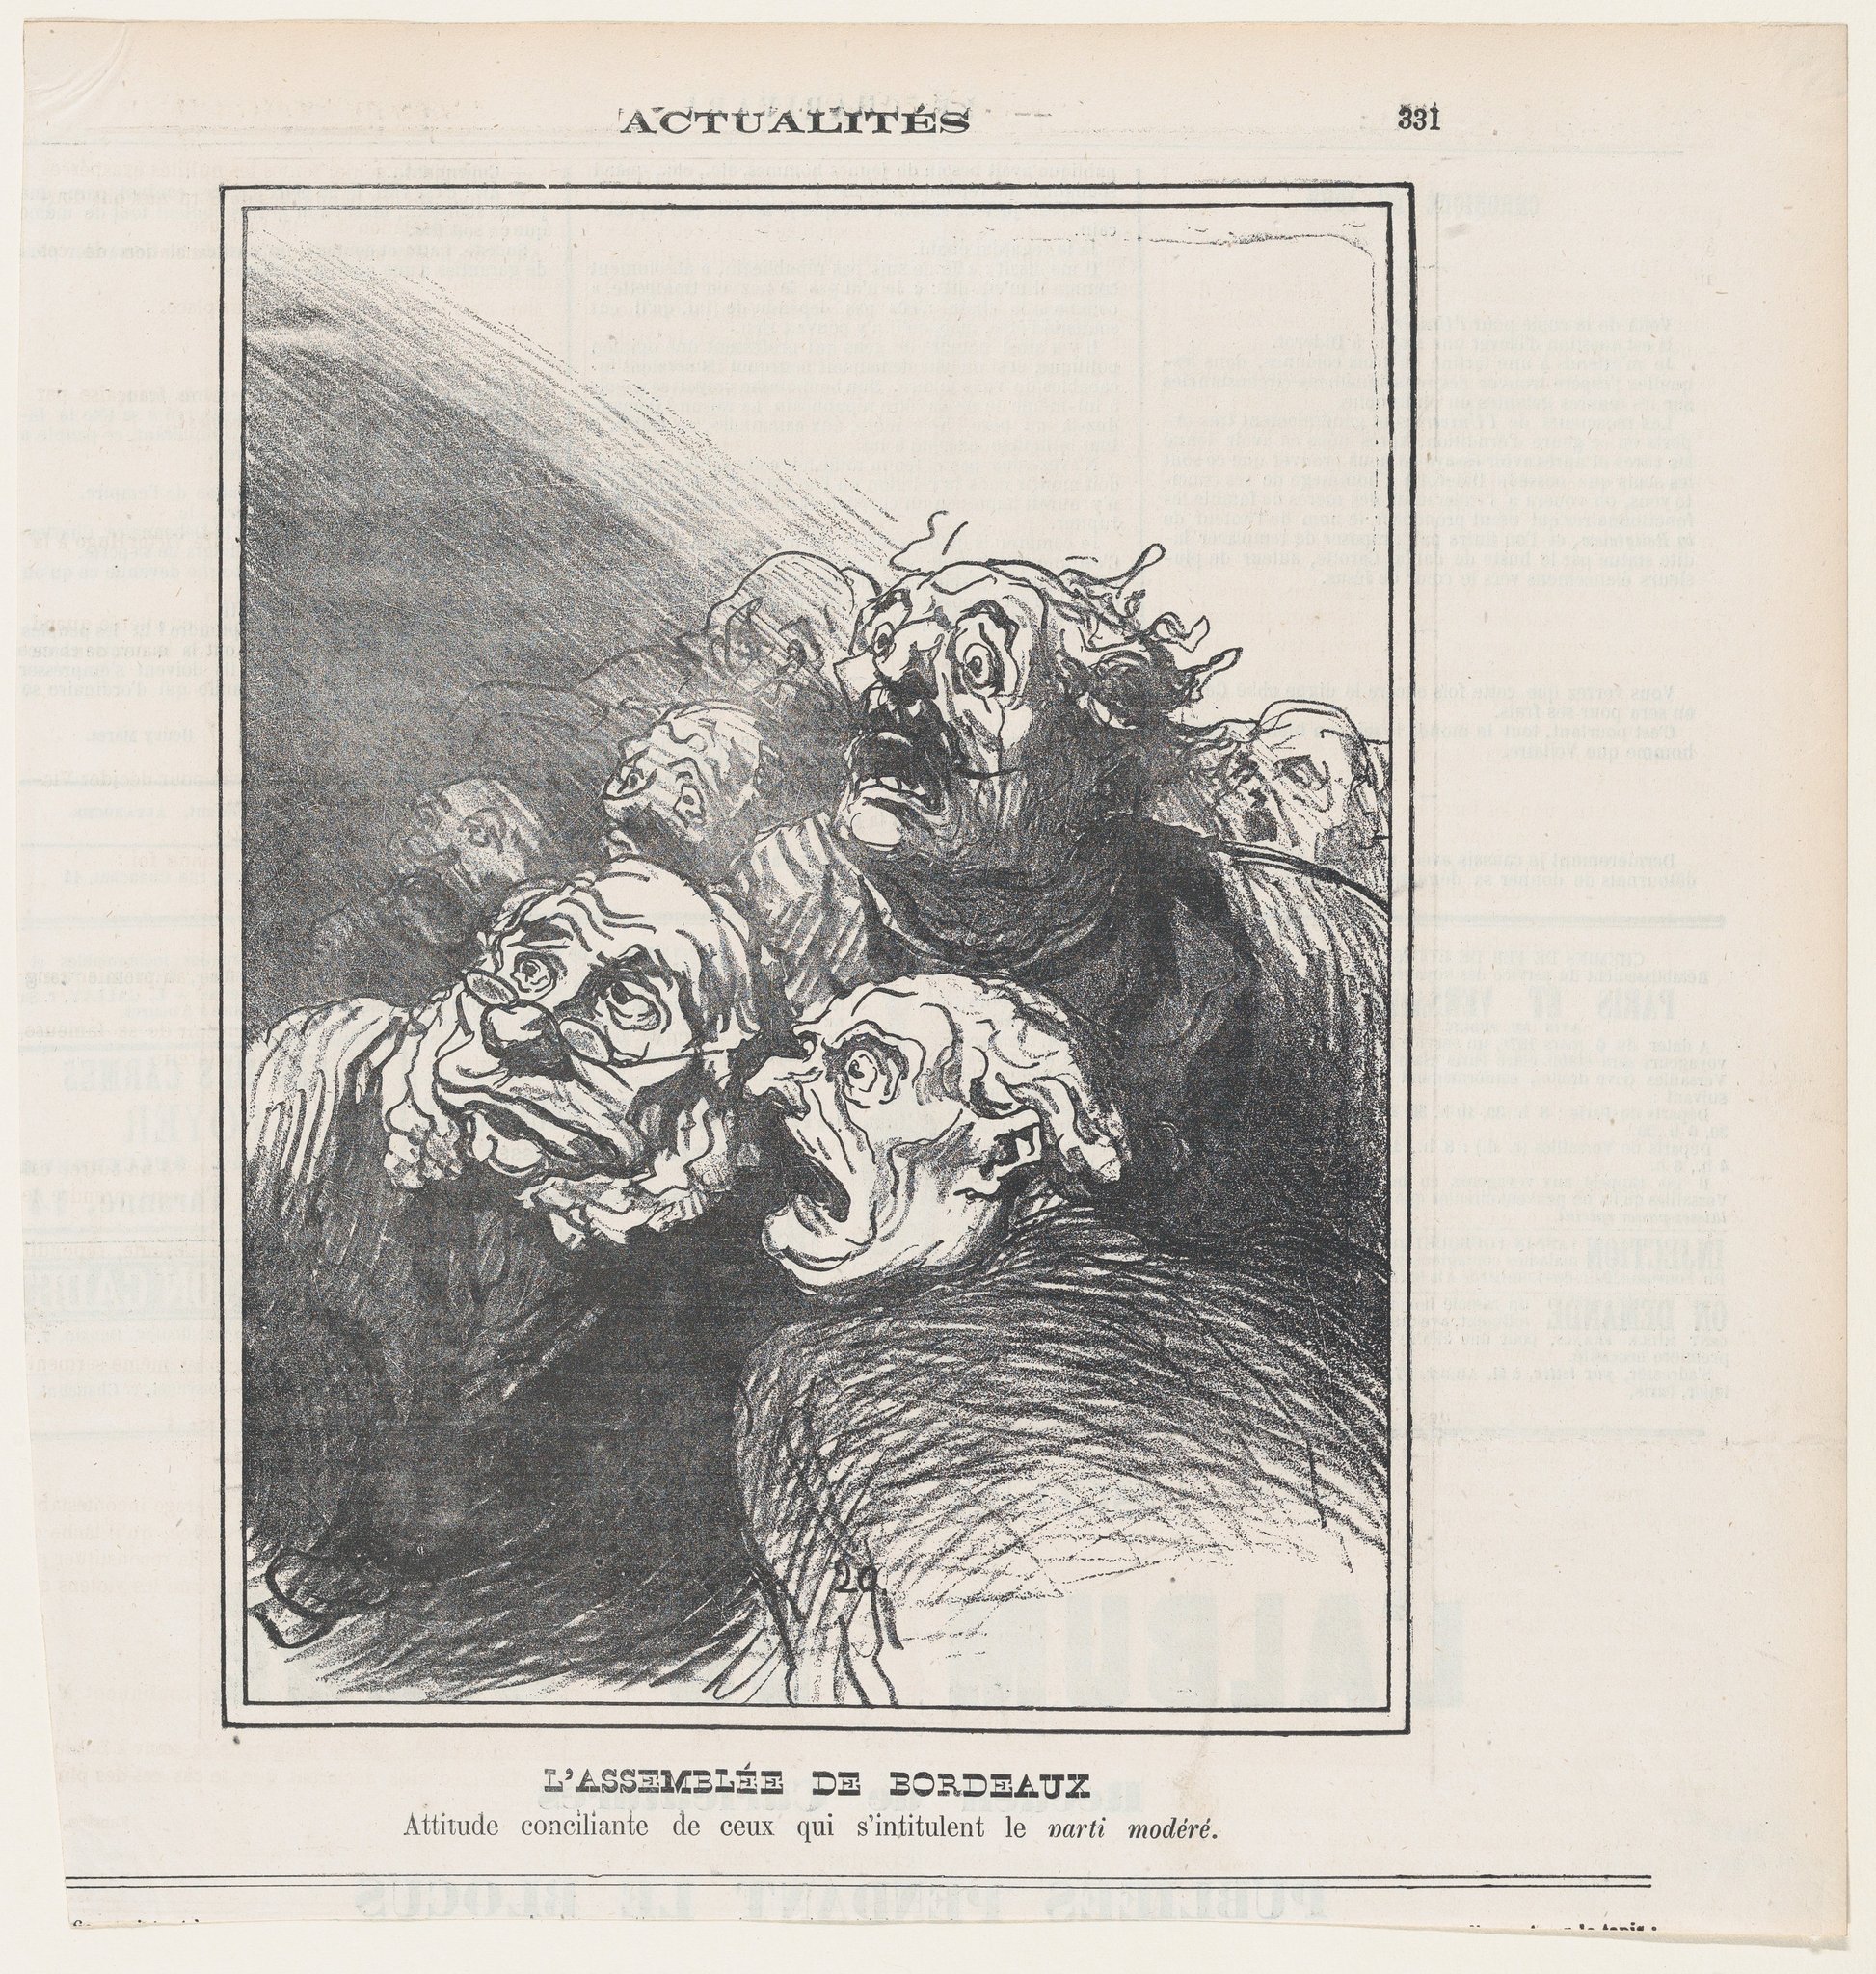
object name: print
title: The Bordeaux Assembly: View of the conciliatory attitude of the 'moderate party', from "News of the day"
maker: honoré daumier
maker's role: artist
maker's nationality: french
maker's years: 1808-1879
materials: paper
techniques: lithograph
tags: satire,men